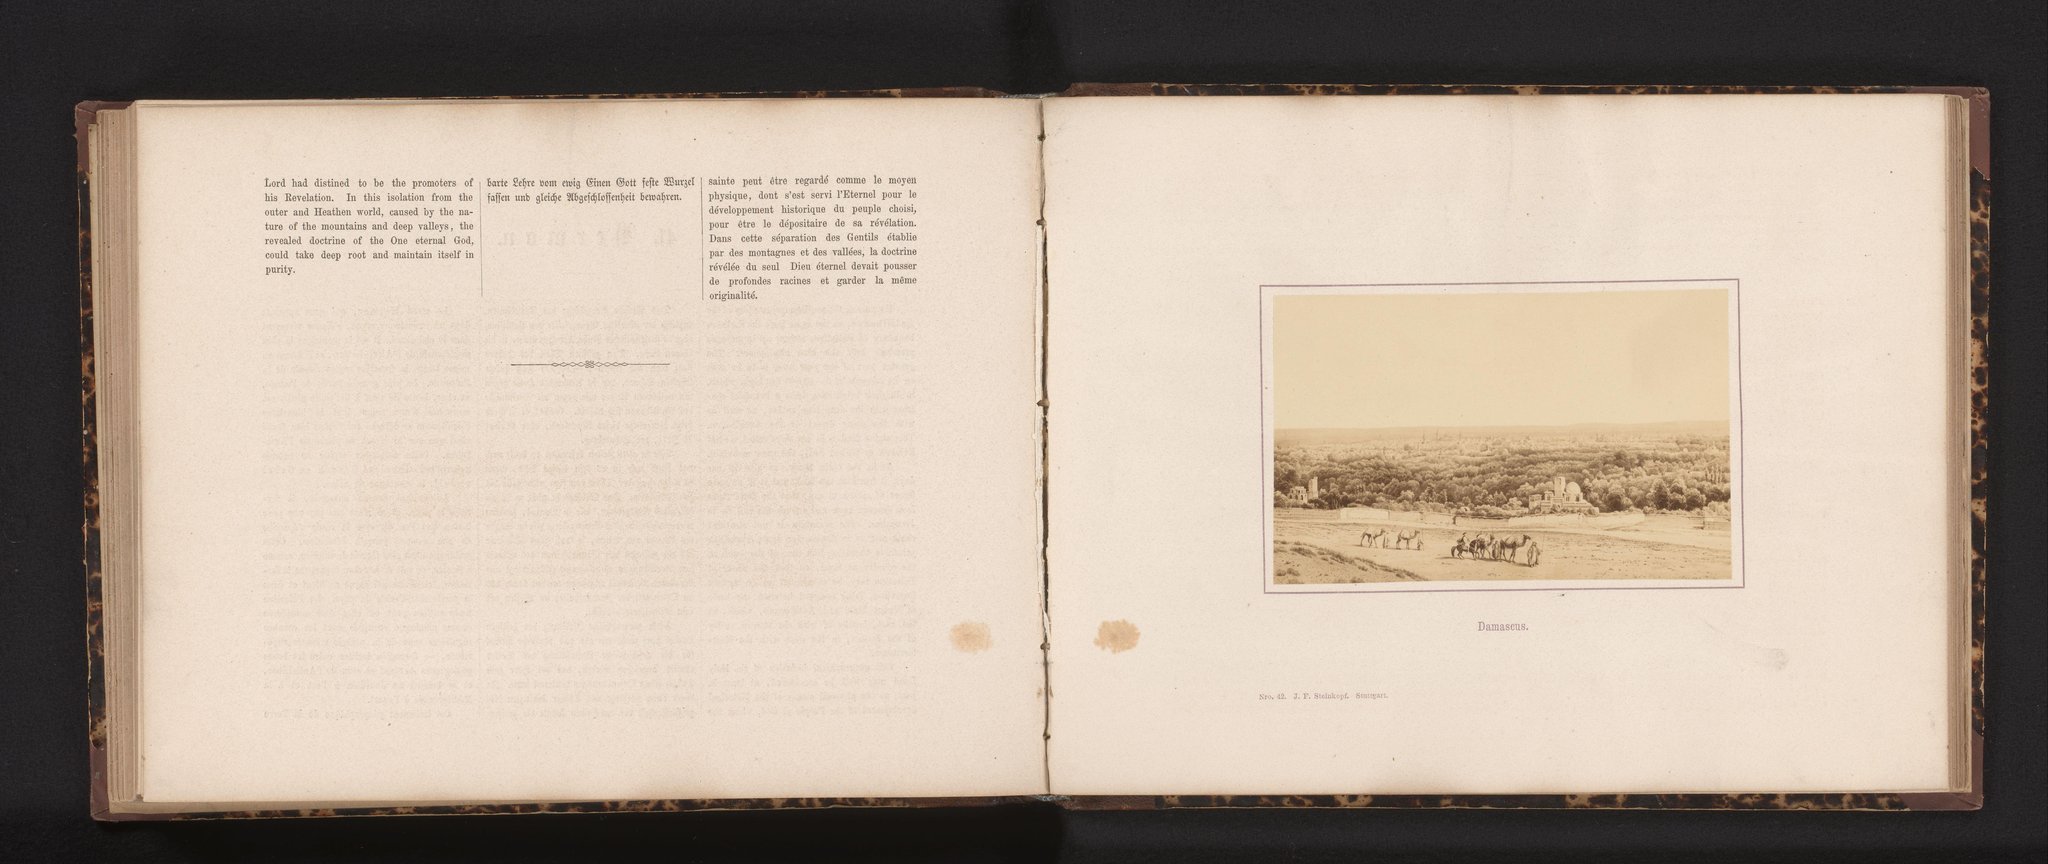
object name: photograph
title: Fotoreproductie van een schilderij, voorstellende een gezicht op Damascus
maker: Anonymous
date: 1858-1868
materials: photographic support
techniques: albumen print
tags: city-view in general; 'veduta'